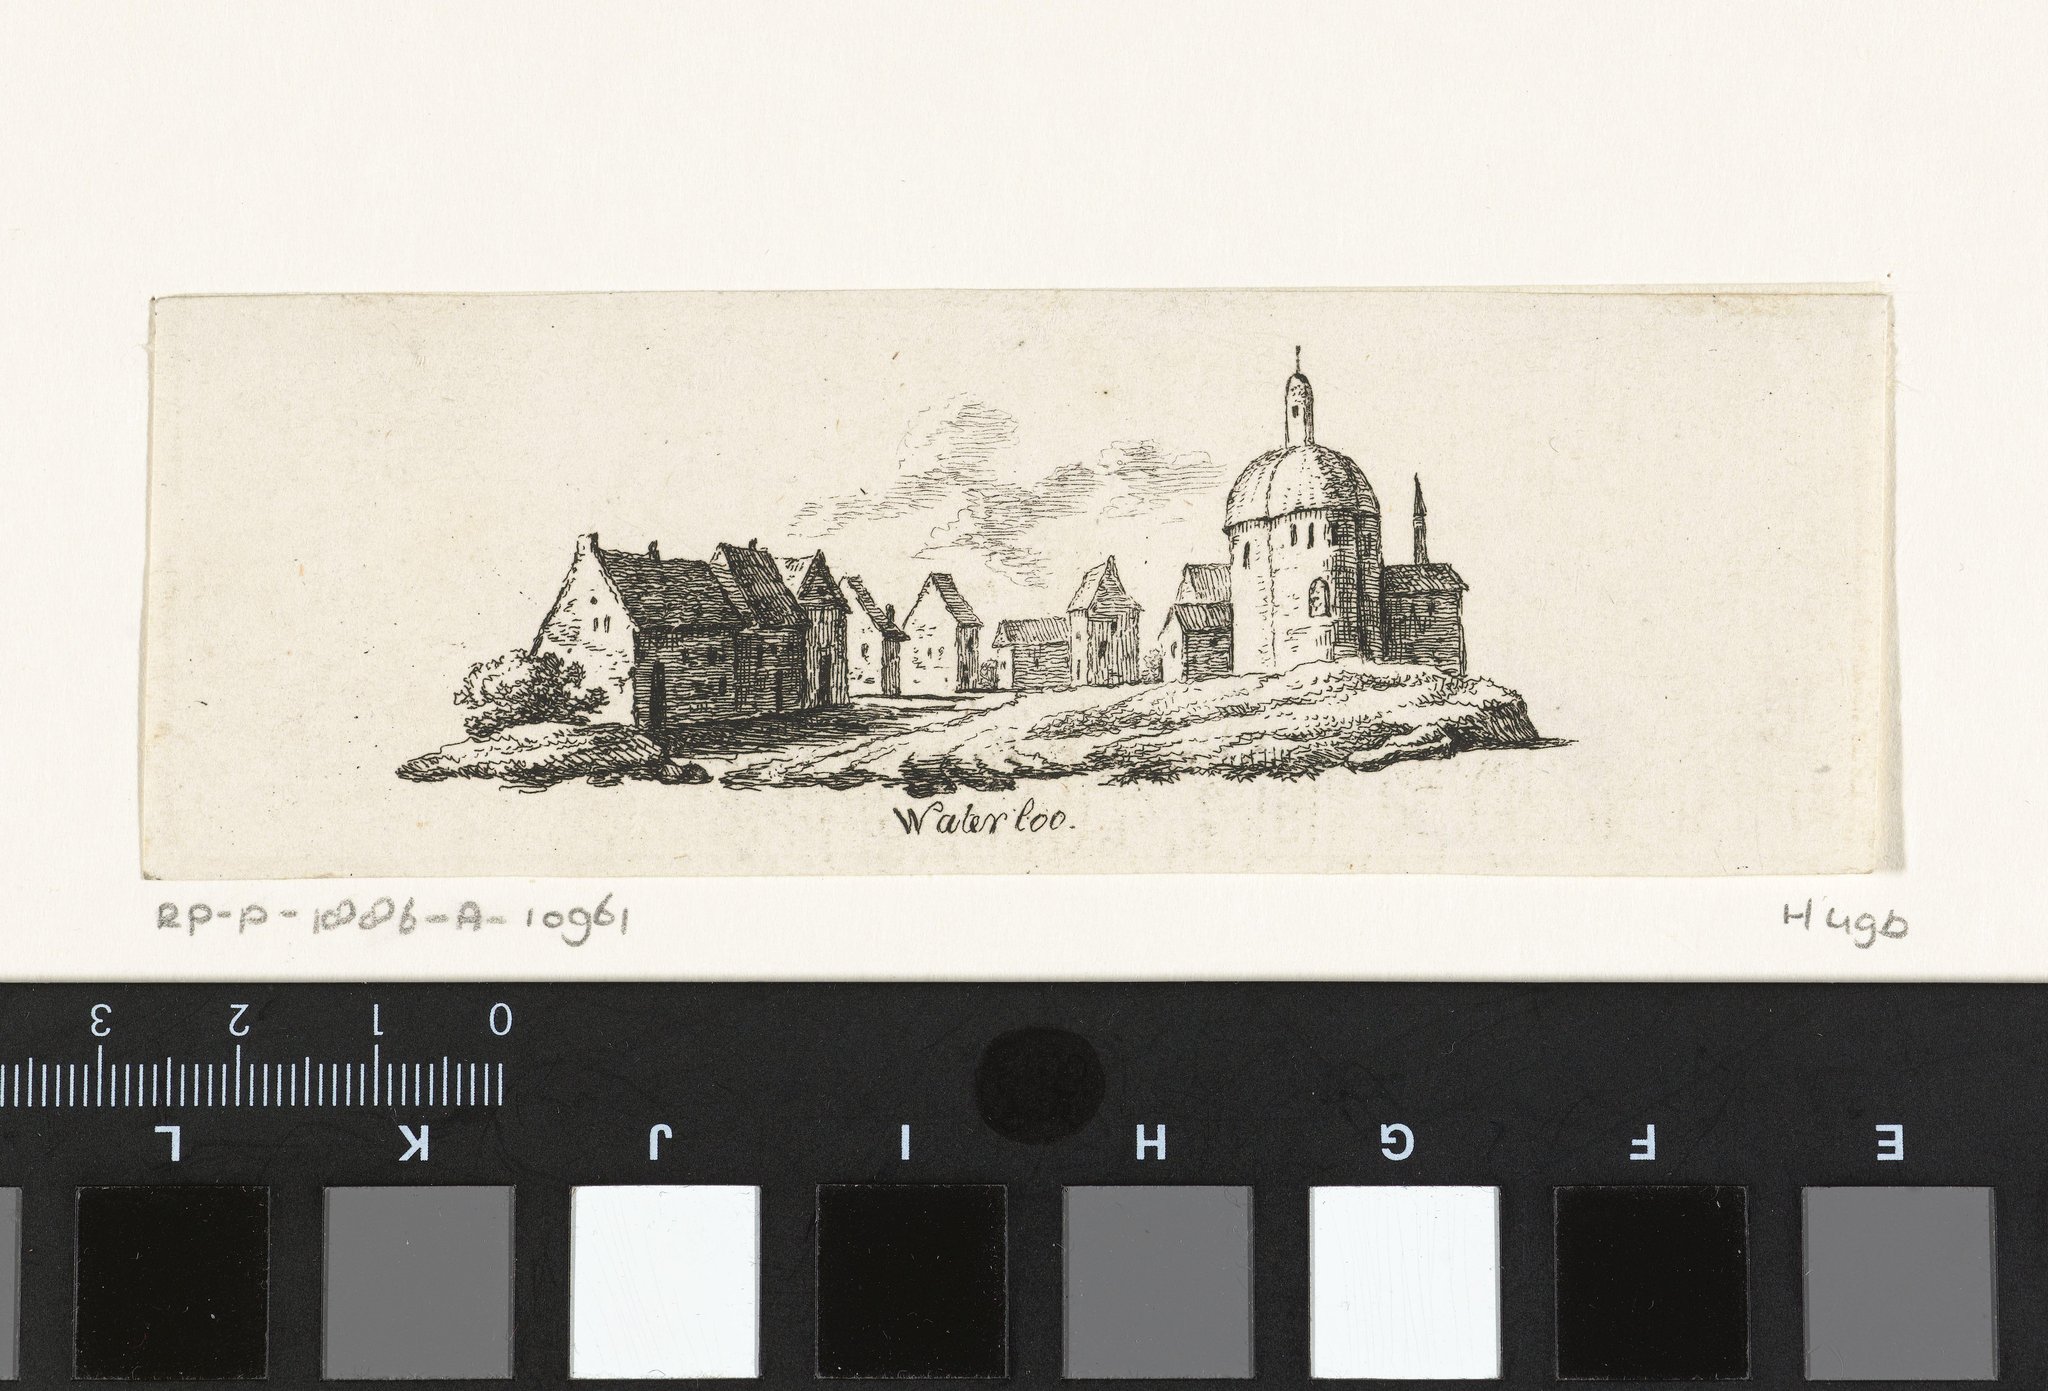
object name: print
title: Waterloo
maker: frédéric théodore faber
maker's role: print maker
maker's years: 1782-1844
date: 1810-1817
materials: paper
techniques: etching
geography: brussels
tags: waterloo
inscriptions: collector's mark: Lugt 2228